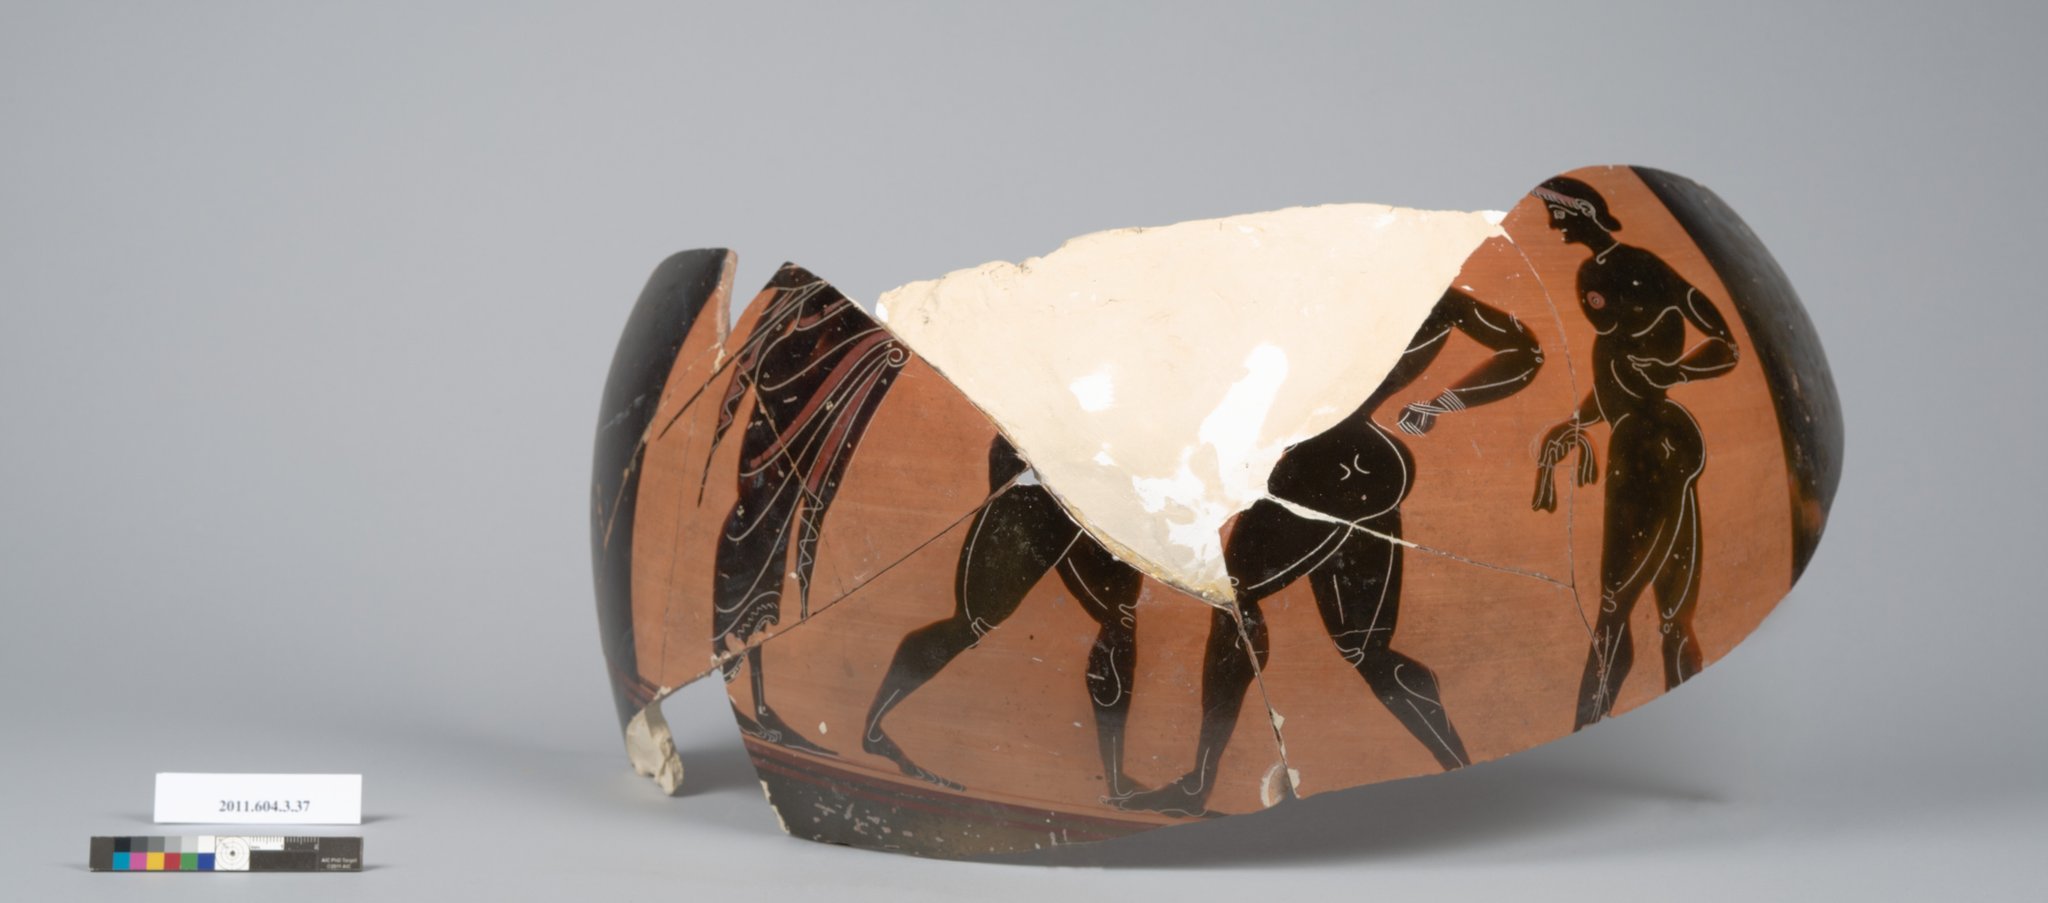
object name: amphora fragment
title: Terracotta fragment of an amphora (jar)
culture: greek, attic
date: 550-526 BCE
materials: terracotta